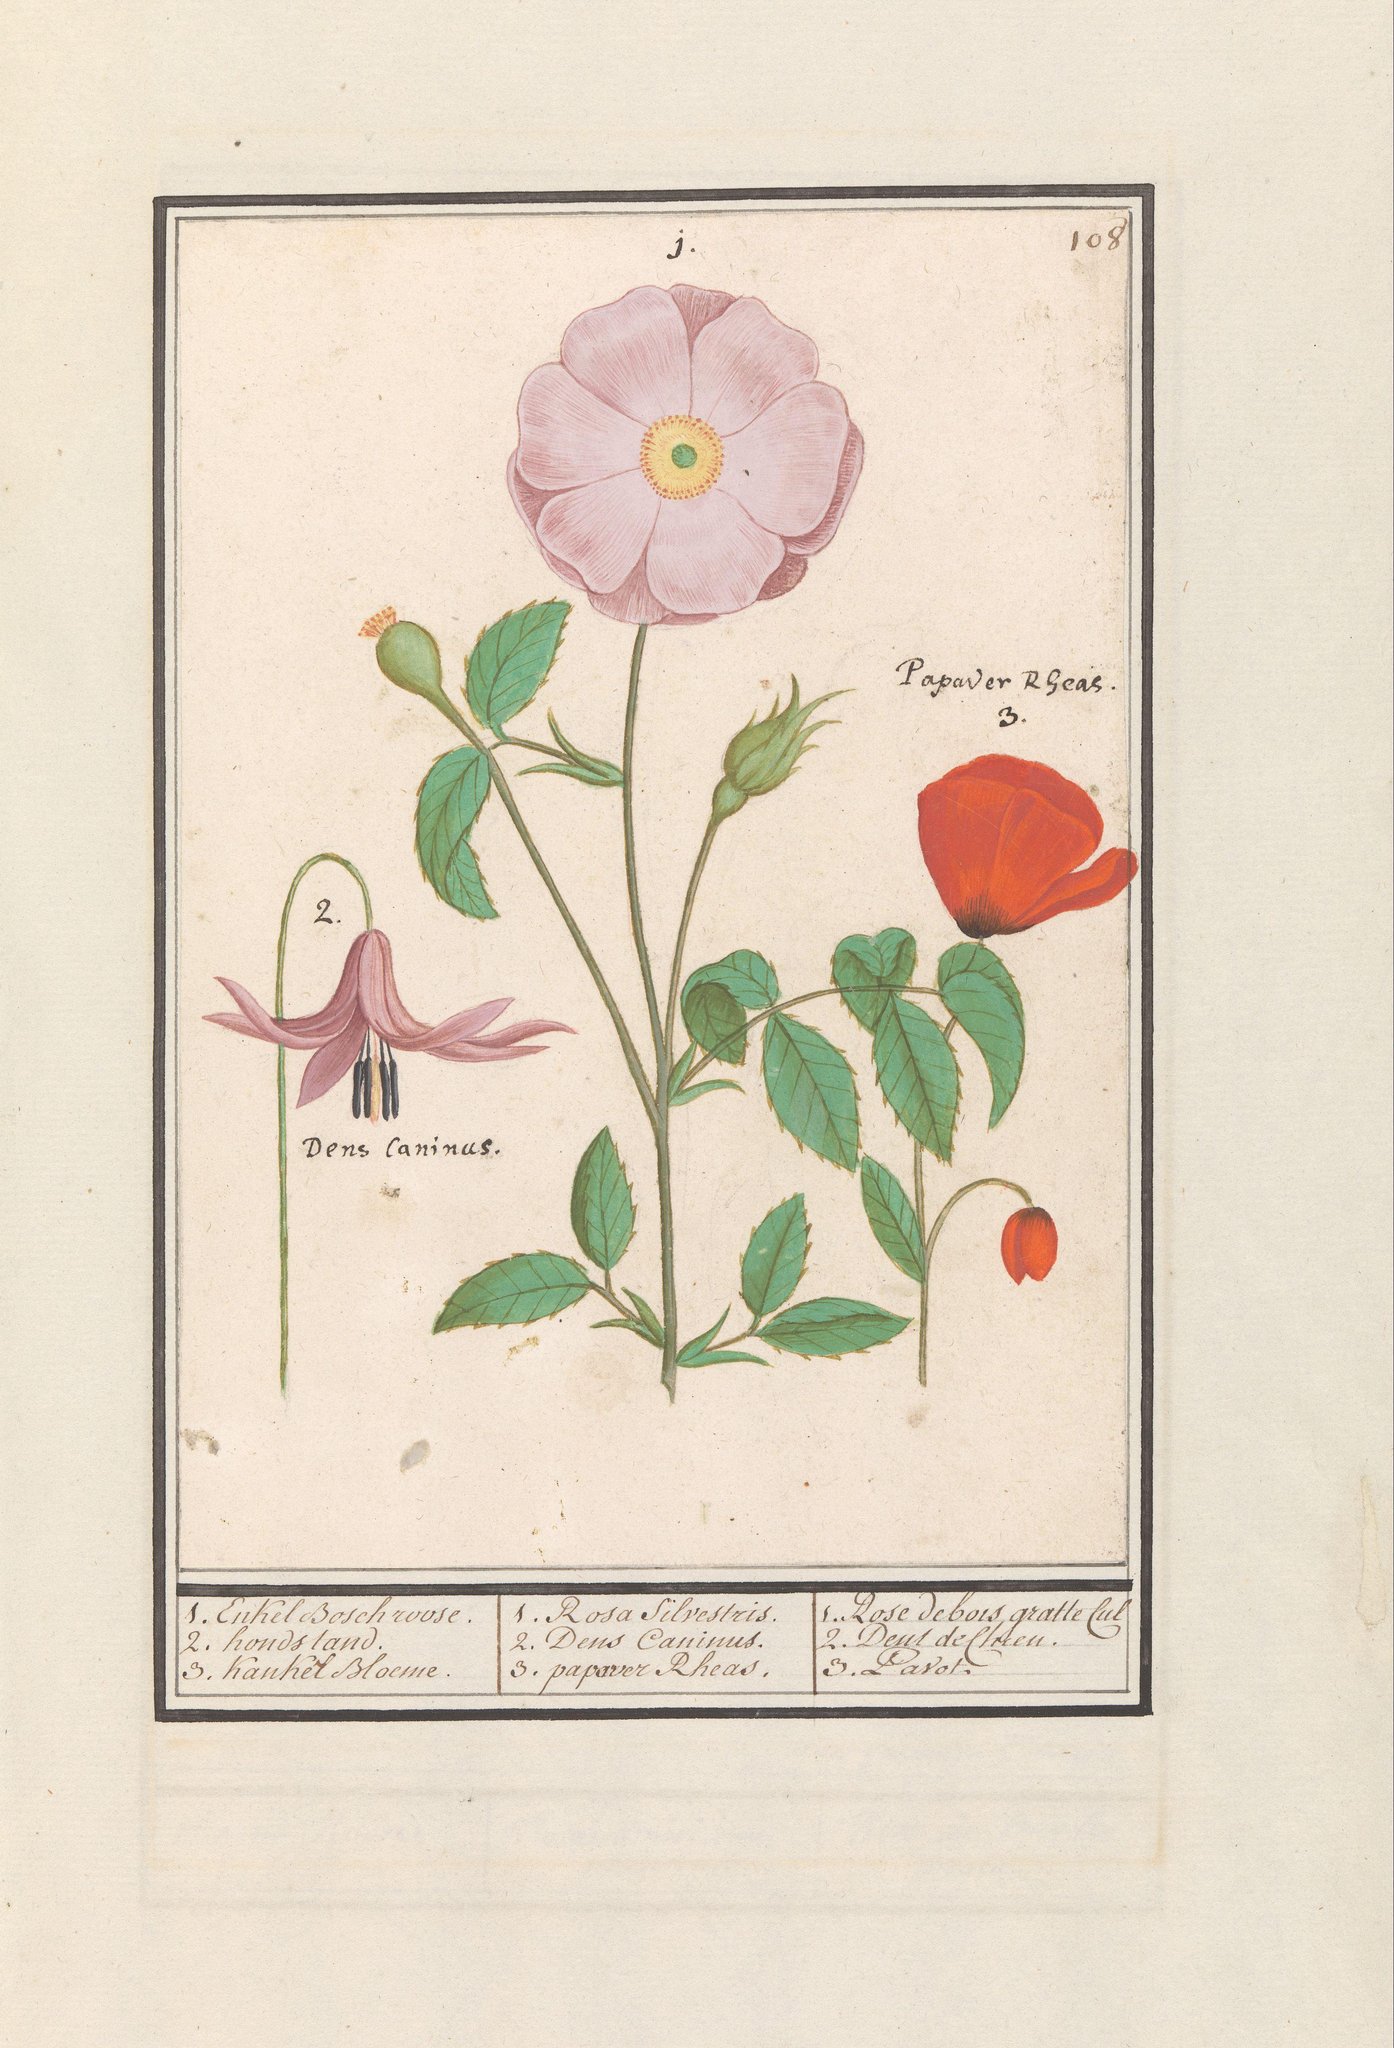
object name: drawing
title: Hondstand (Erythronium), wilde roos (Rosa) en een klaproos (Papaver)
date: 1596-1610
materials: paint, ink, paper, watercolor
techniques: brush, pen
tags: flowers: erythronium, flowers: rose, flowers: poppy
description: Hondstand, roos en klaproos. Rechtsboven genummerd: 108. Met de Latijnse namen. Onderdeel van het tweede album met tekeningen van bloemen en planten. Negende van twaalf albums met tekeningen van dieren, vogels en planten bekend rond 1600, gemaakt in opdracht van keizer Rudolf II. Met toelichting in Nederlands, Latijn en Frans.